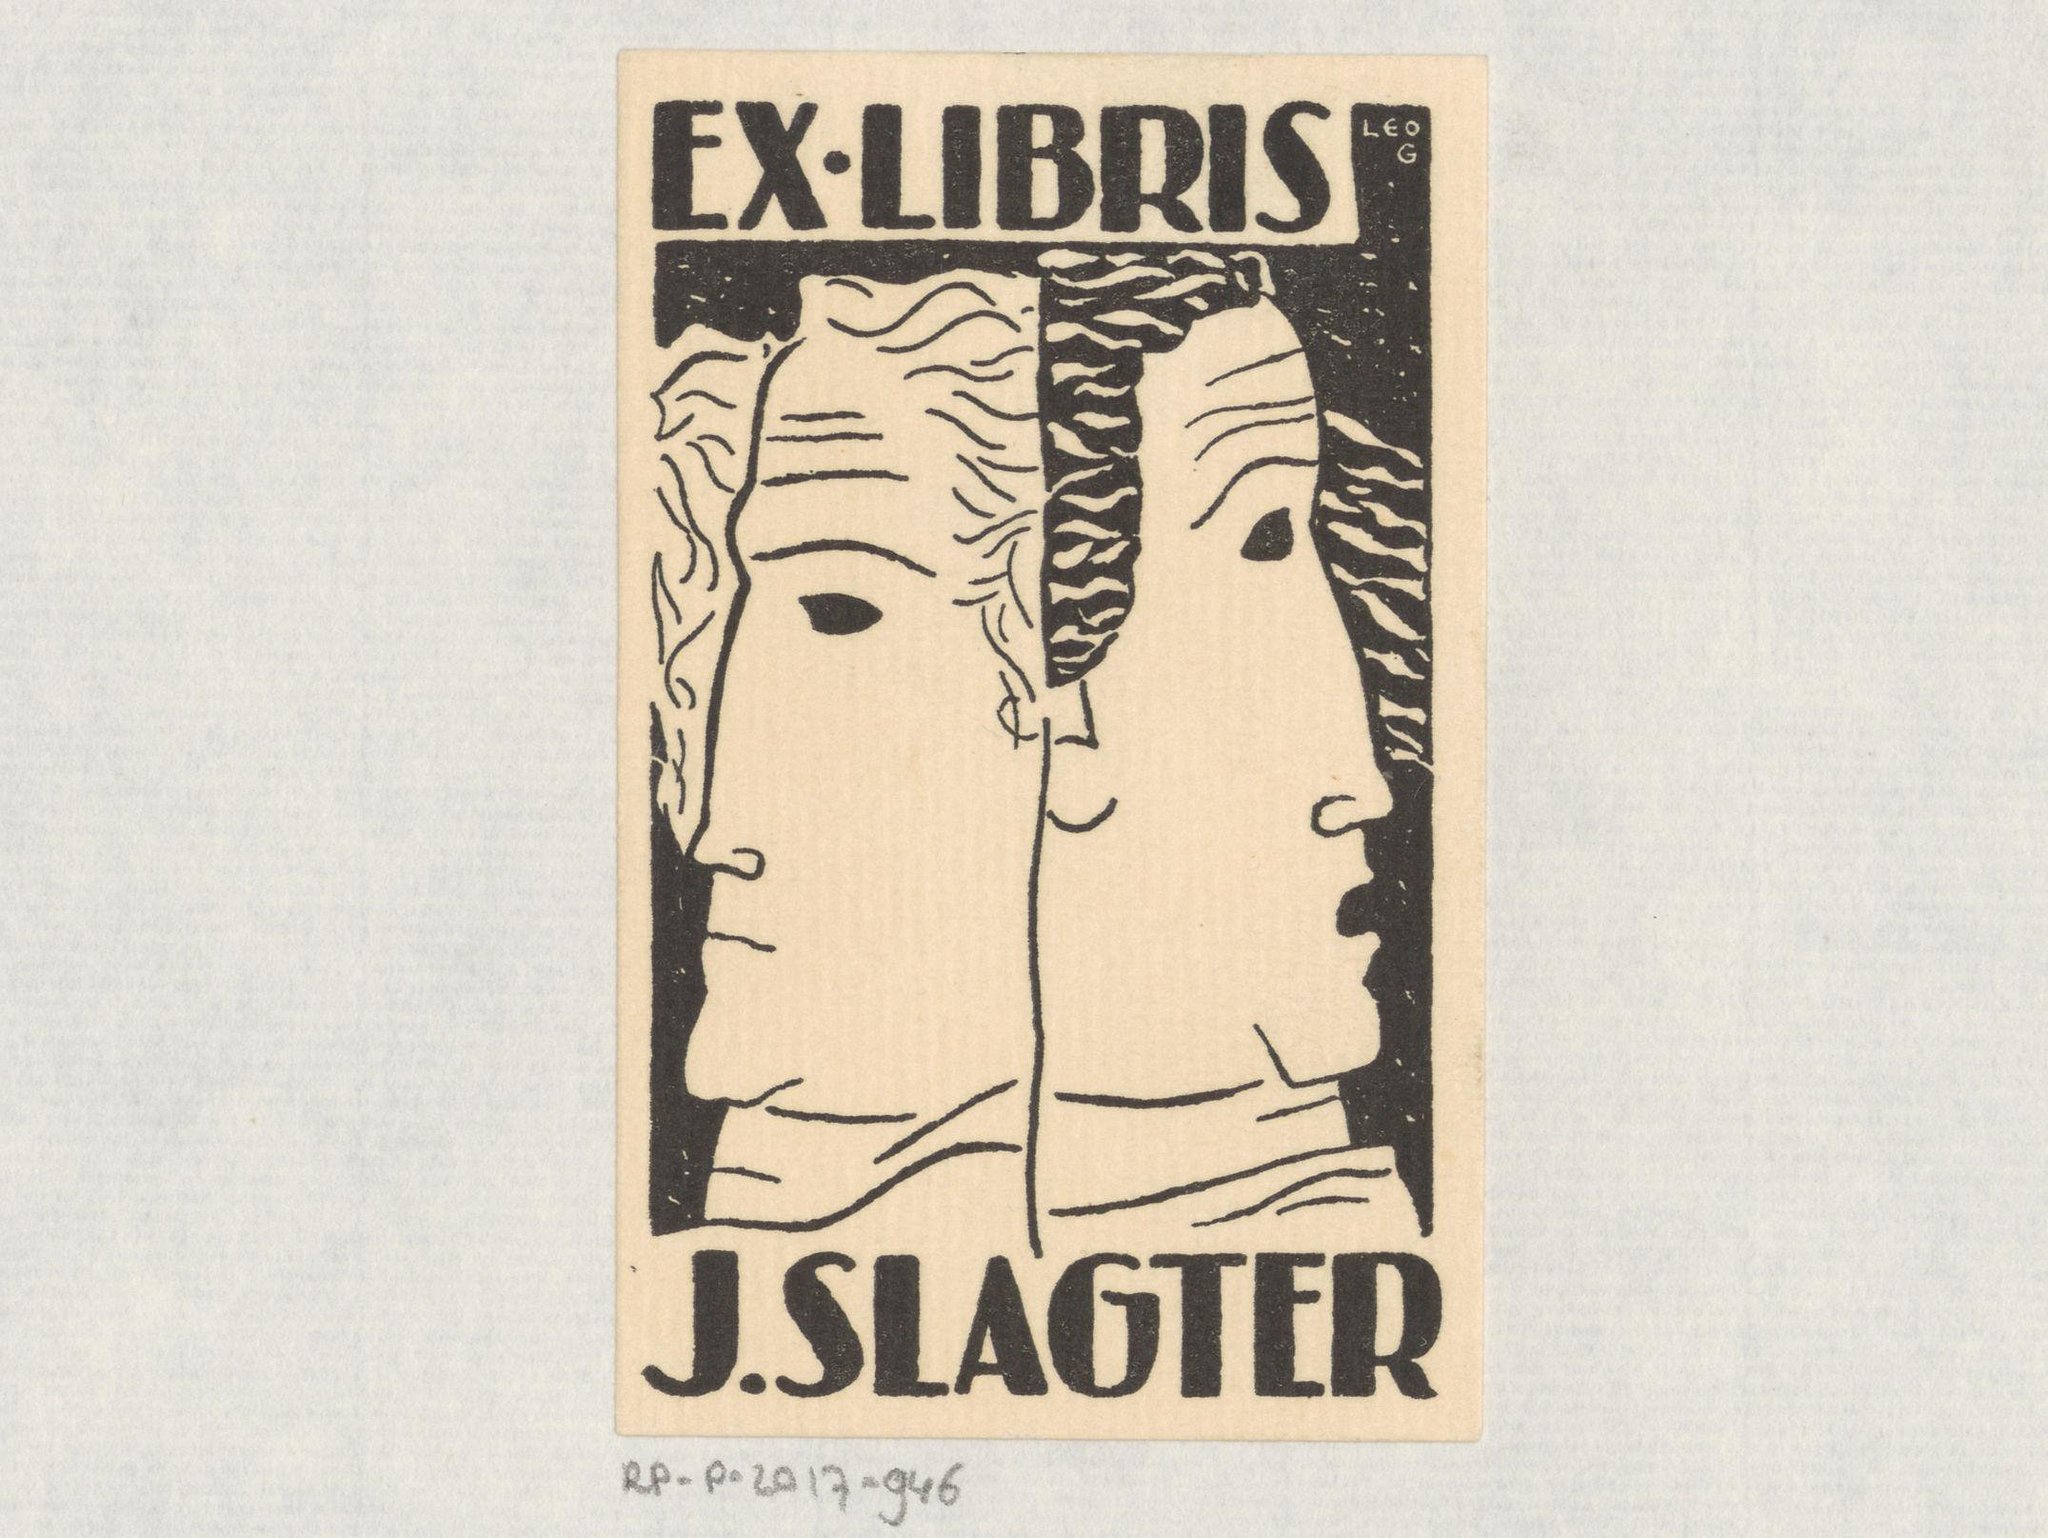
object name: bookplate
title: Ex libris van J. Slagter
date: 1933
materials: paper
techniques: printing block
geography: netherlands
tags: adult man, head turned sideways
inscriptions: inscription: ‘Cl. Leo Gestel / 1933’